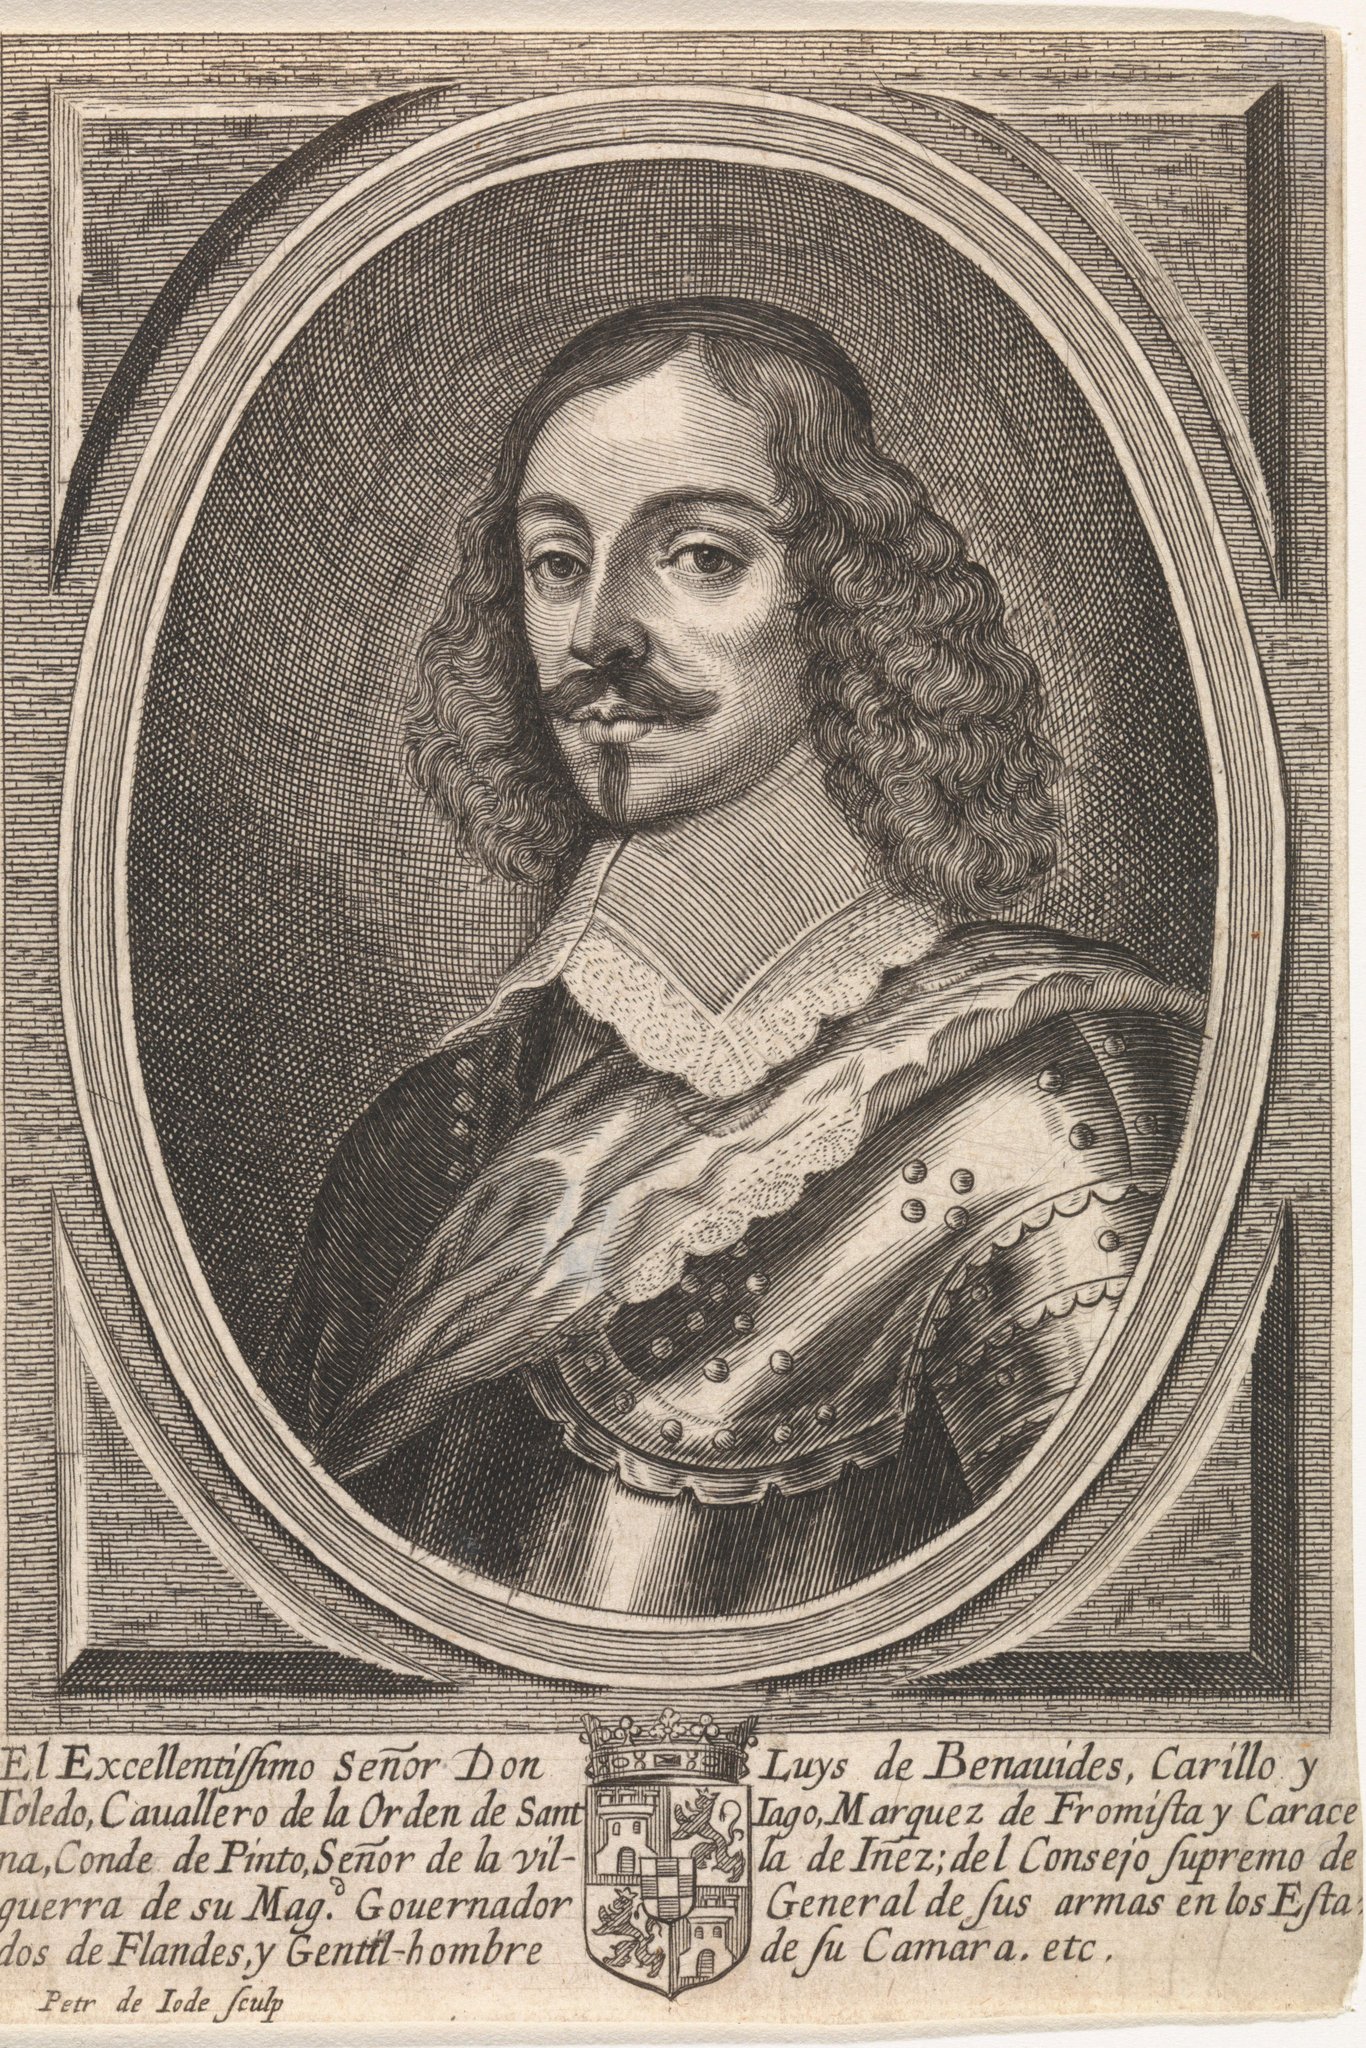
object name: print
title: Portret van Luis de Benavides Carillo de Toledo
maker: pieter de jode (ii)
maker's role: draughtsman, print maker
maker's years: 1606-1674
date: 1628-1670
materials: paper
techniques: engraving, etching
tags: armour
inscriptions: collector's mark: Lugt 2166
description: Busteportret van Luis de Benavides Carillo de Toledo, met kalot. Hij draagt een harnas. Het portret is gevat in een ovale omlijsting met vierkant randwerk. In de marge het wapenschild van de geportretteerde en een vijfregelig onderschrift in het Spaans.